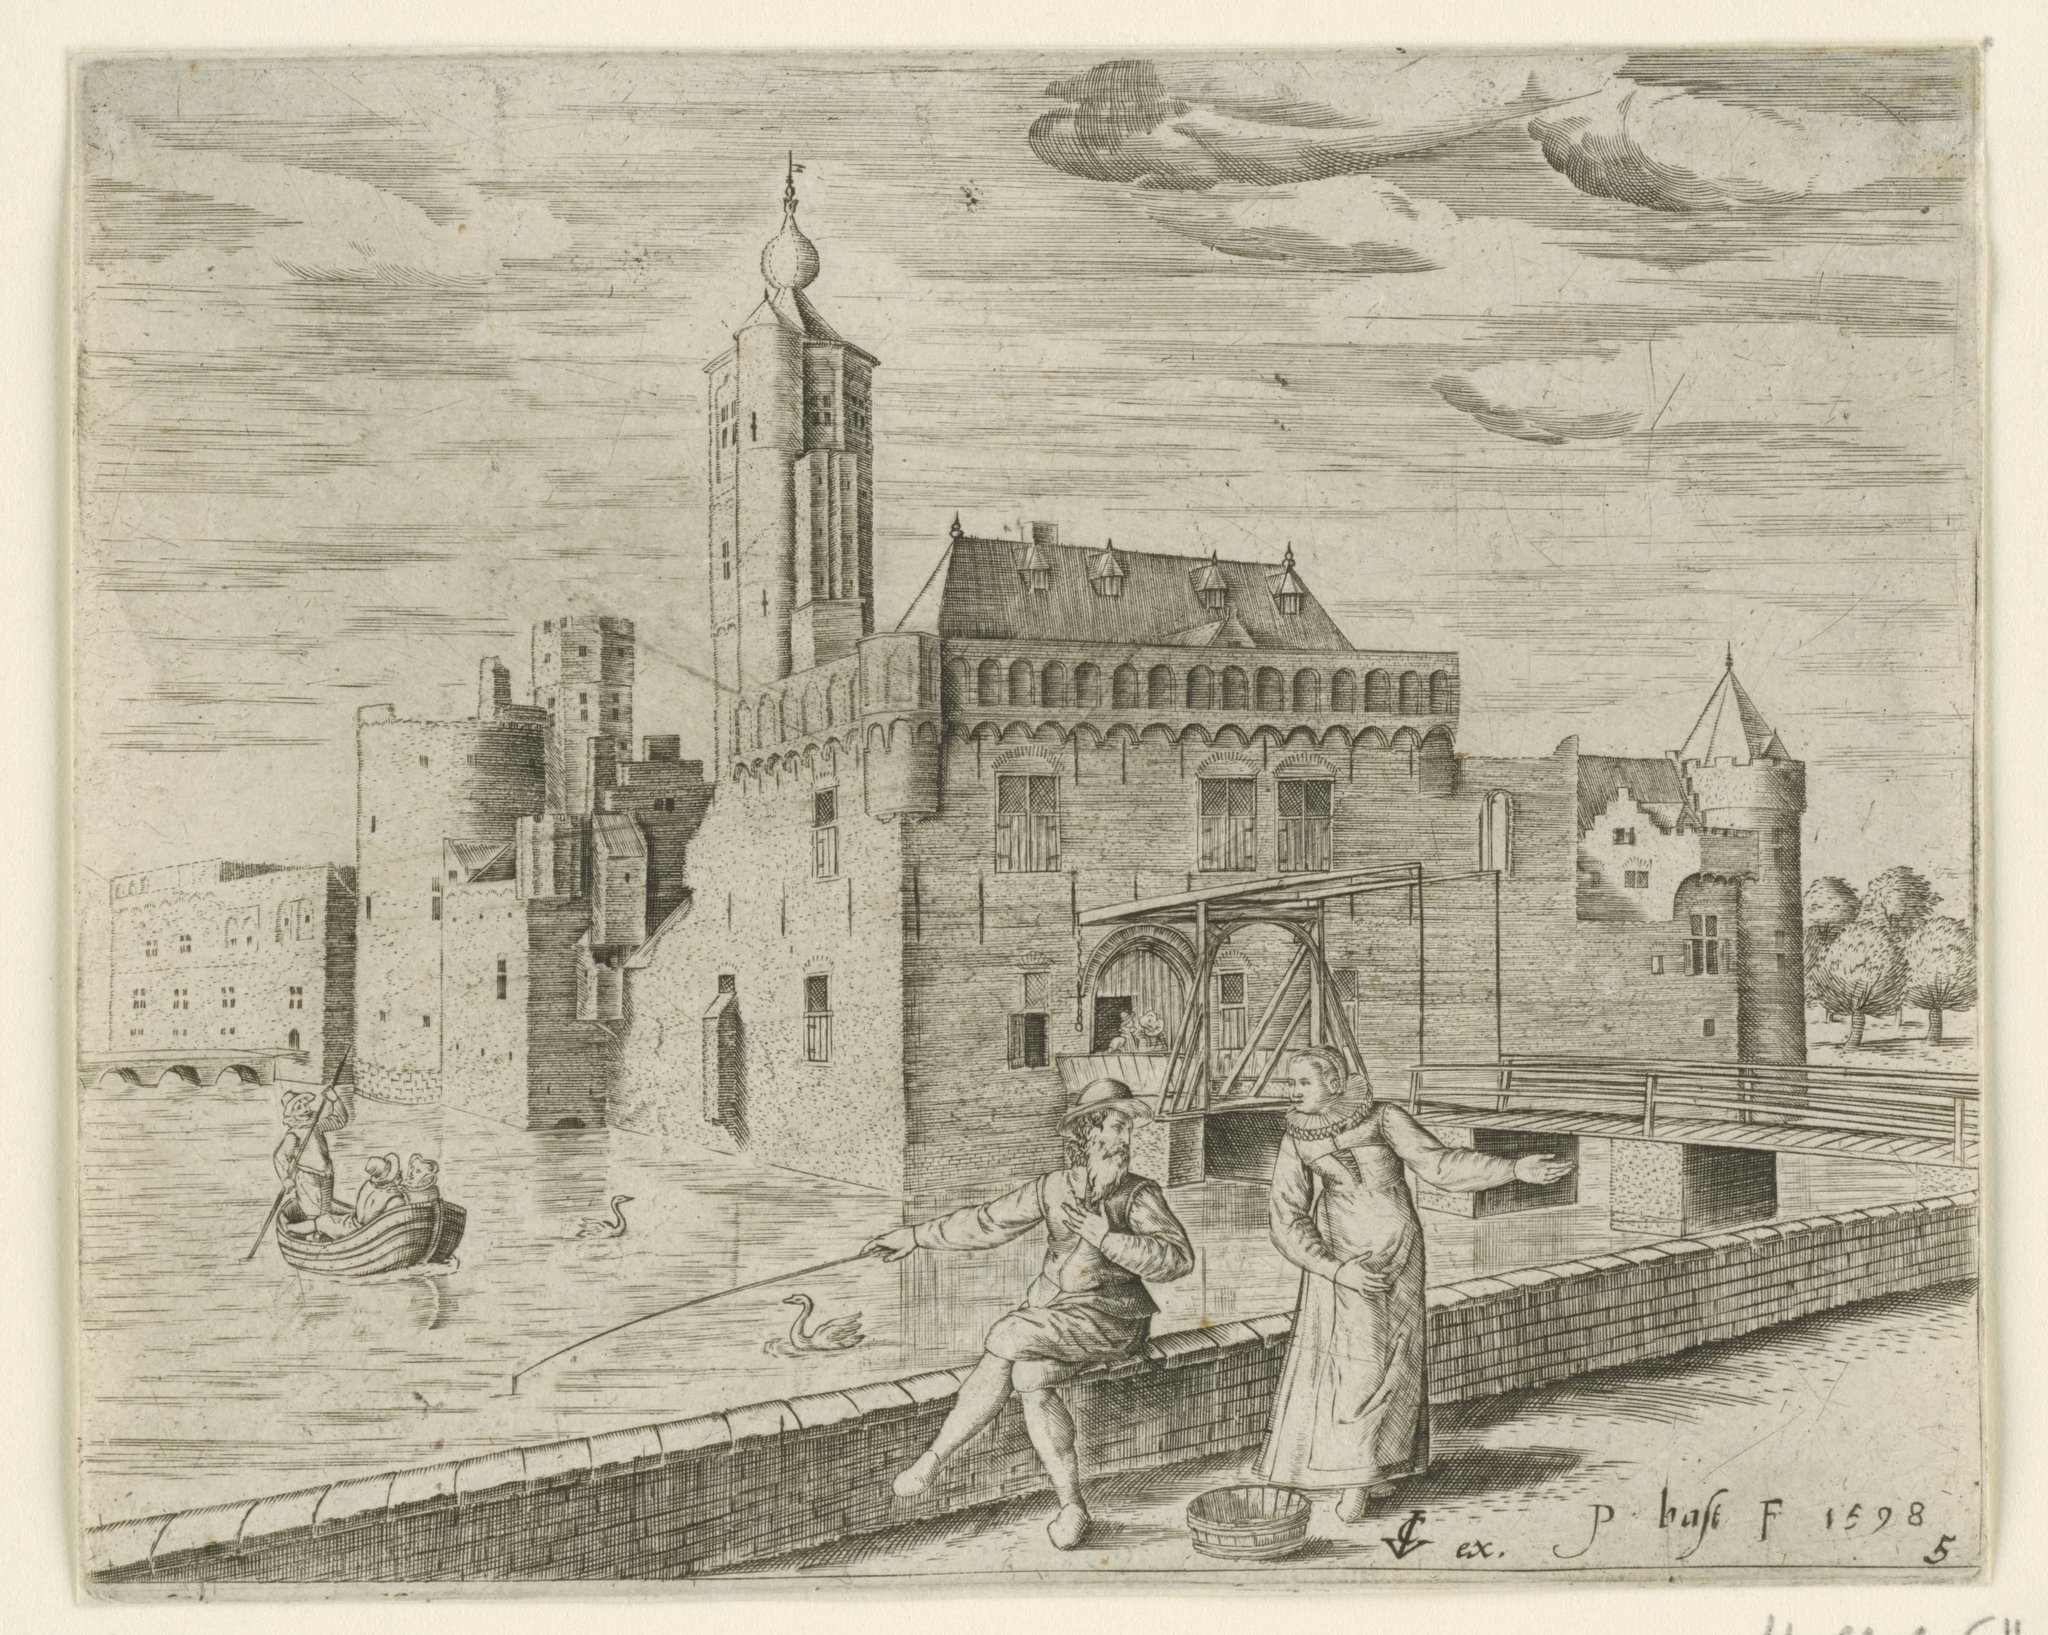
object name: print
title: Landschappen met bijbelse scènes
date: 1598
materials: paper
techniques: engraving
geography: amsterdam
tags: angling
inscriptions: collector's mark: Lugt 2228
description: Gezicht op het kasteel Aldegonde met op de voorgrond een hengelaar zittend op een muurtje en een vrouw die hem toespreekt. In de slotgracht een roeibootje.